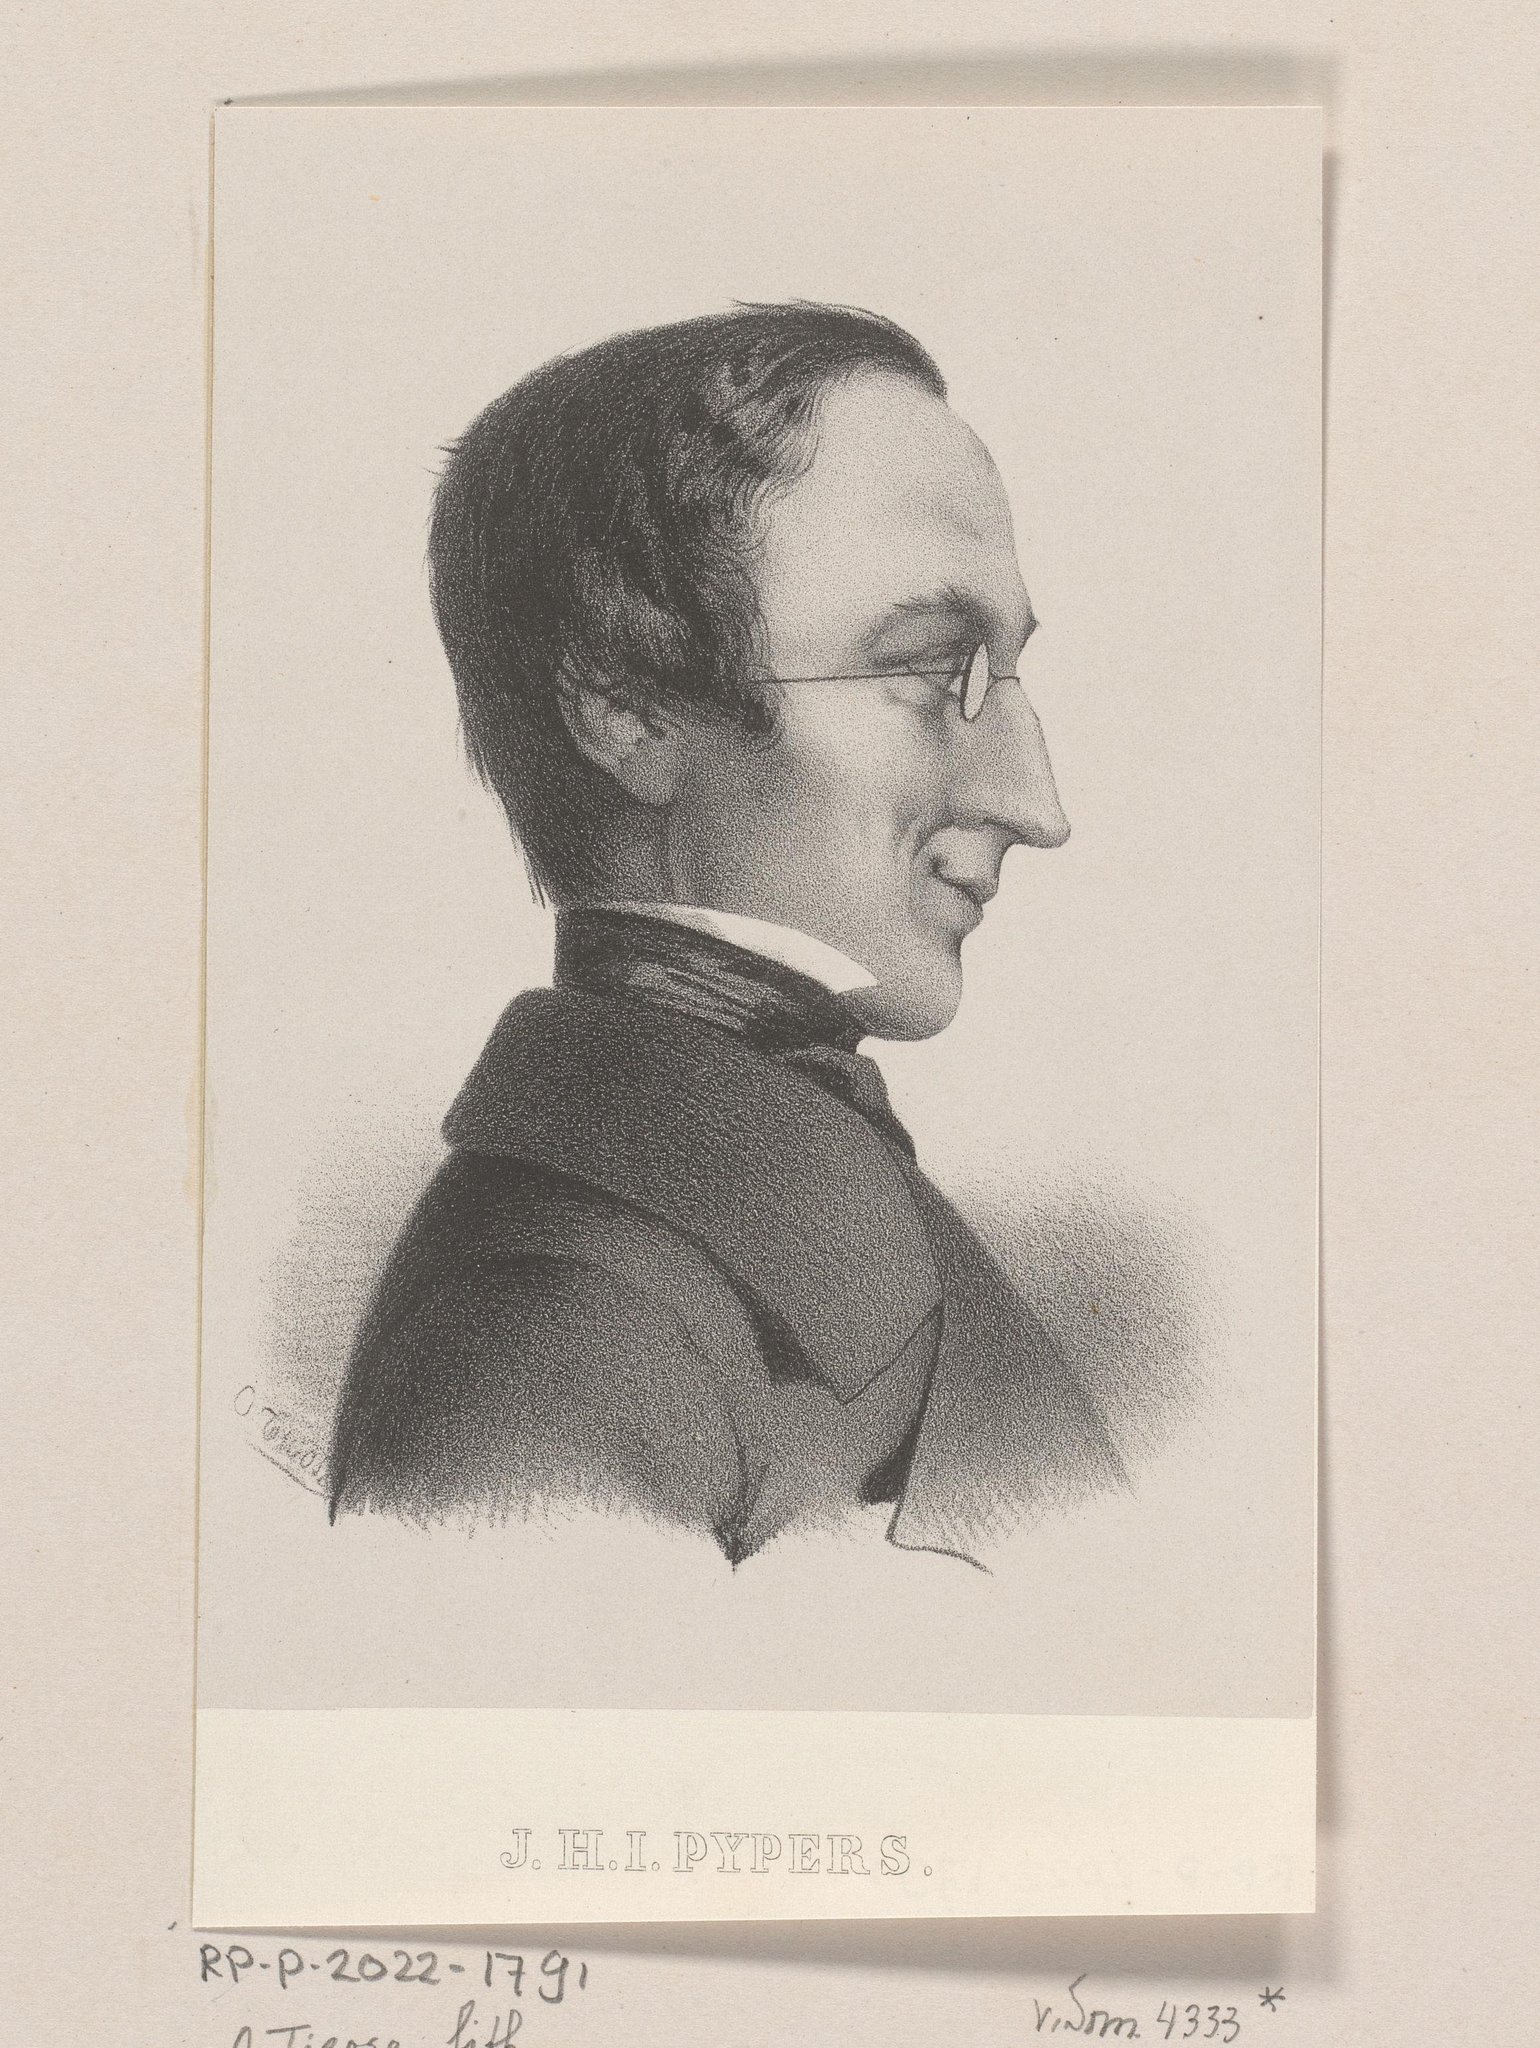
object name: print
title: Portret van Joseph Ignace Hubert Pypers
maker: Anonymous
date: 1832-1899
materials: paper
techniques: lithograph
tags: historical persons, chemistry (+ scholar, scientist (at work))